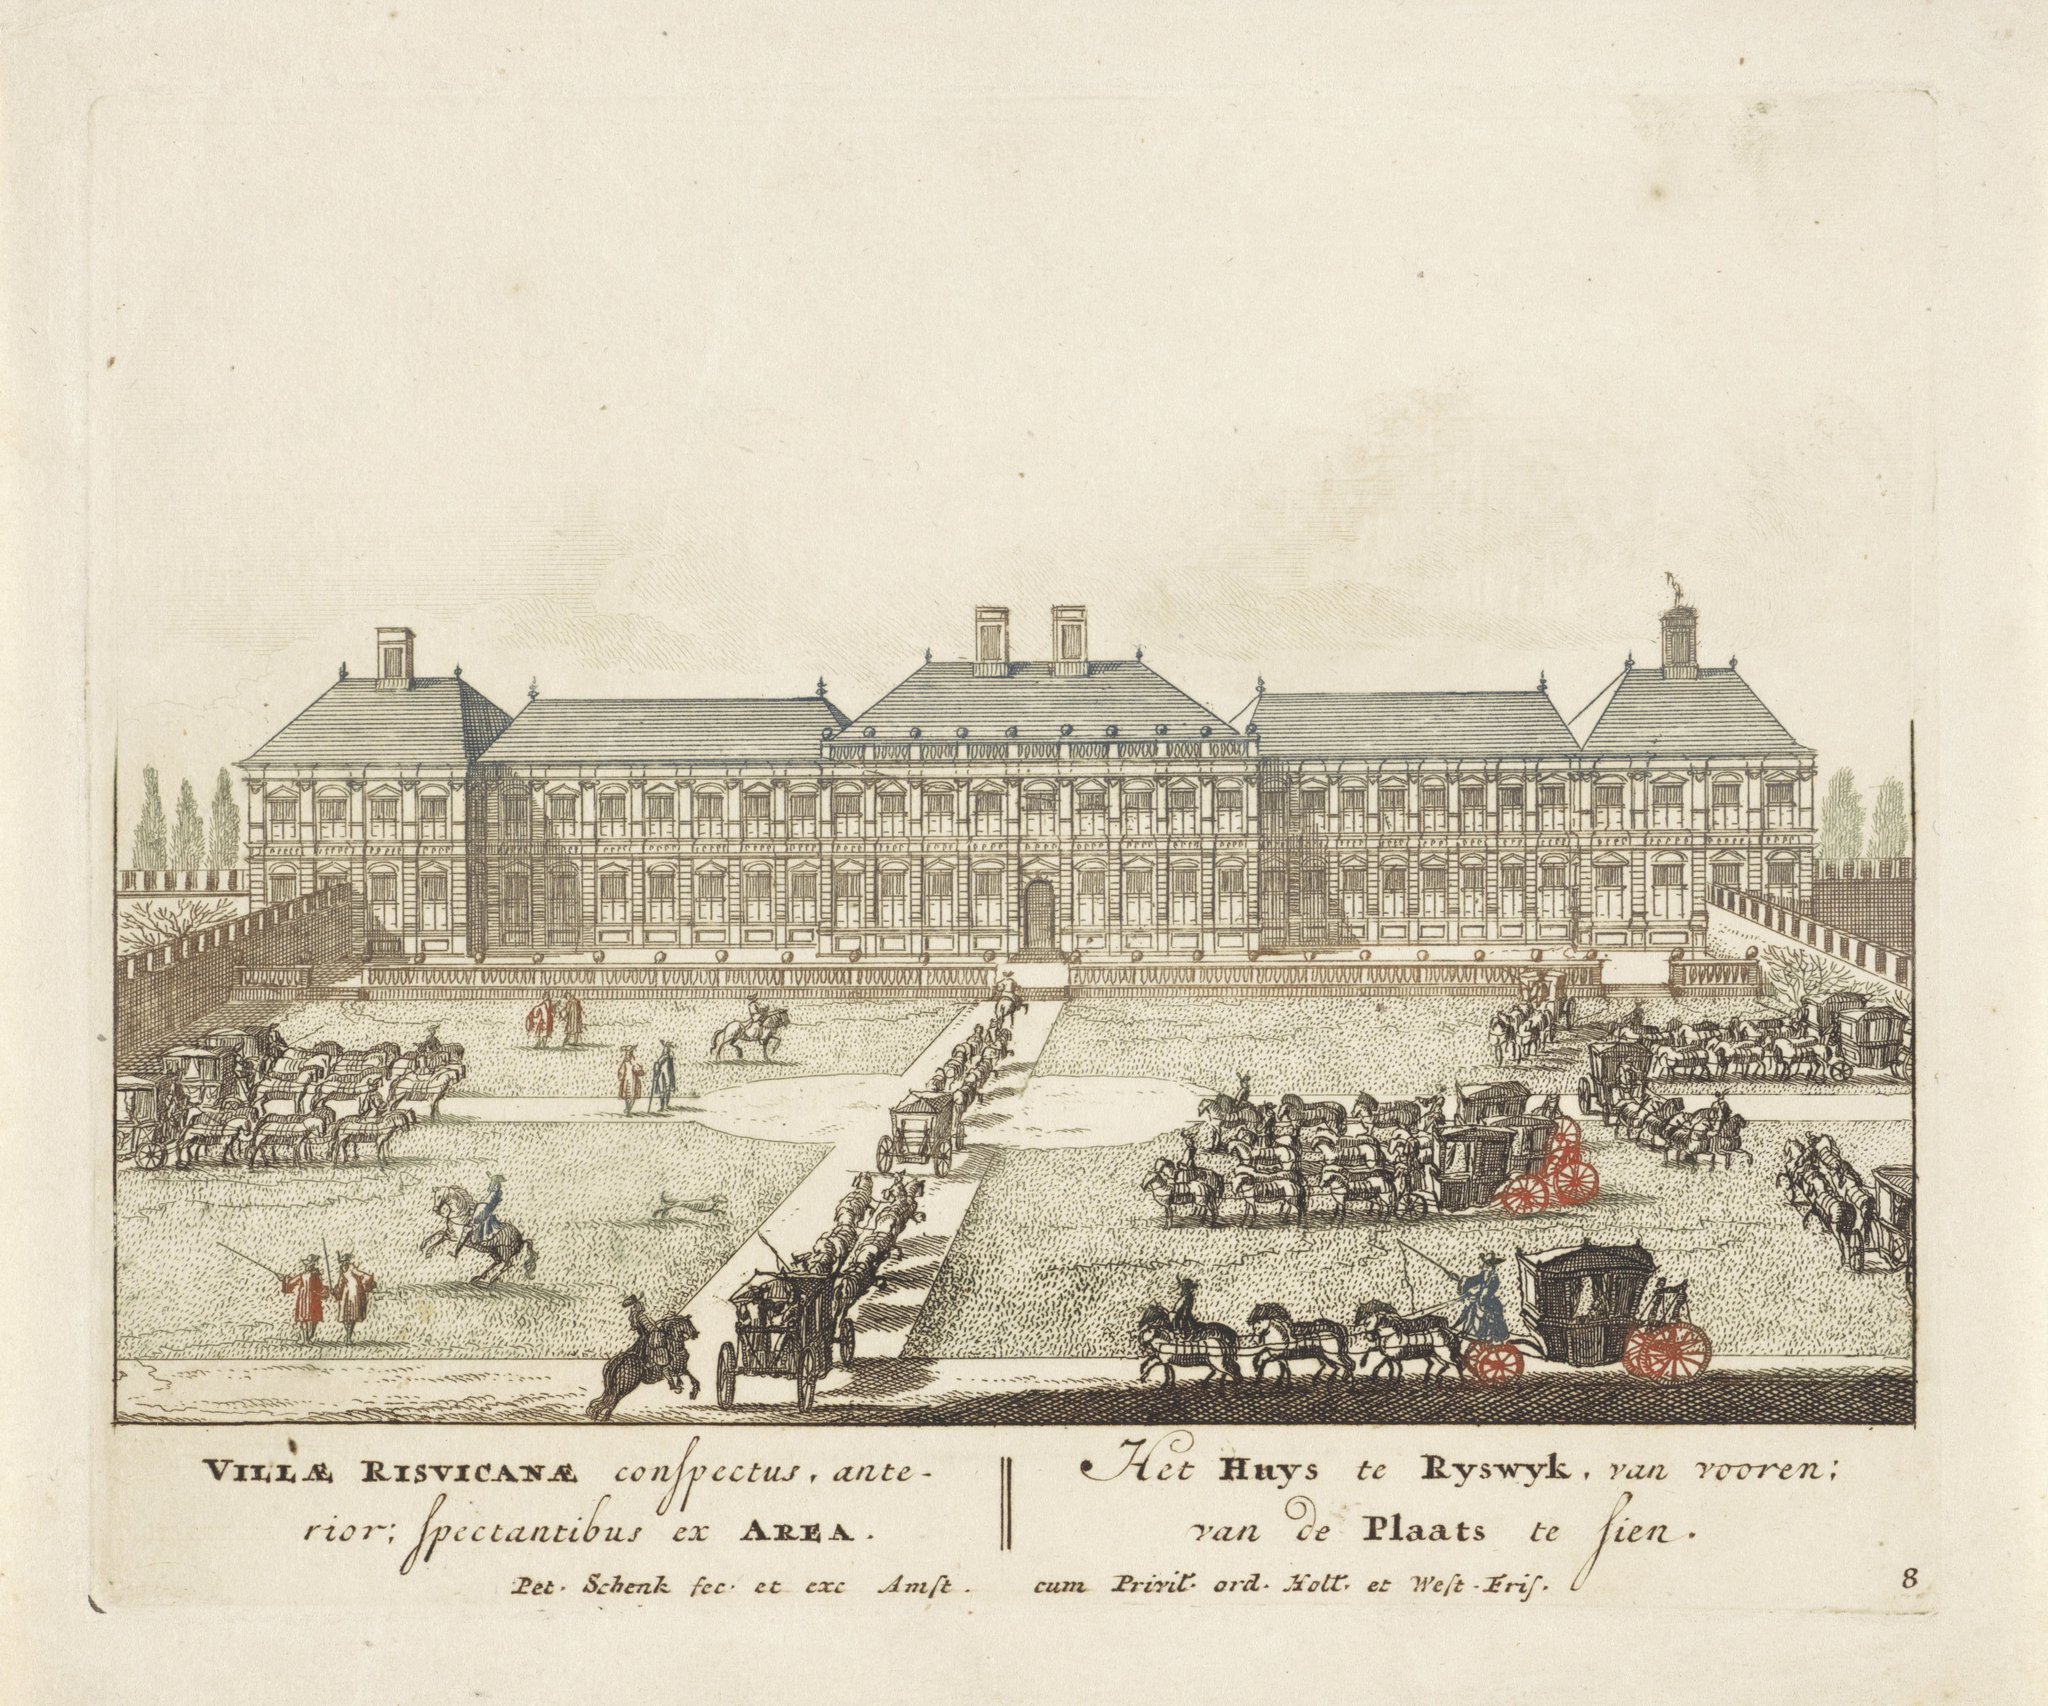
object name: print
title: Gezichten op Huis ter Nieuburch te Rijswijk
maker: pieter schenk (i)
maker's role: print maker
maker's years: 1660-1711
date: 1697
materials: paper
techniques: etching, lithography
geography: amsterdam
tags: palace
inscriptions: collector's mark: Lugt 2228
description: Vooraanzicht van Huis ter Nieuburch te Rijswijk met op de voorgrond op het voorplein koetsen.